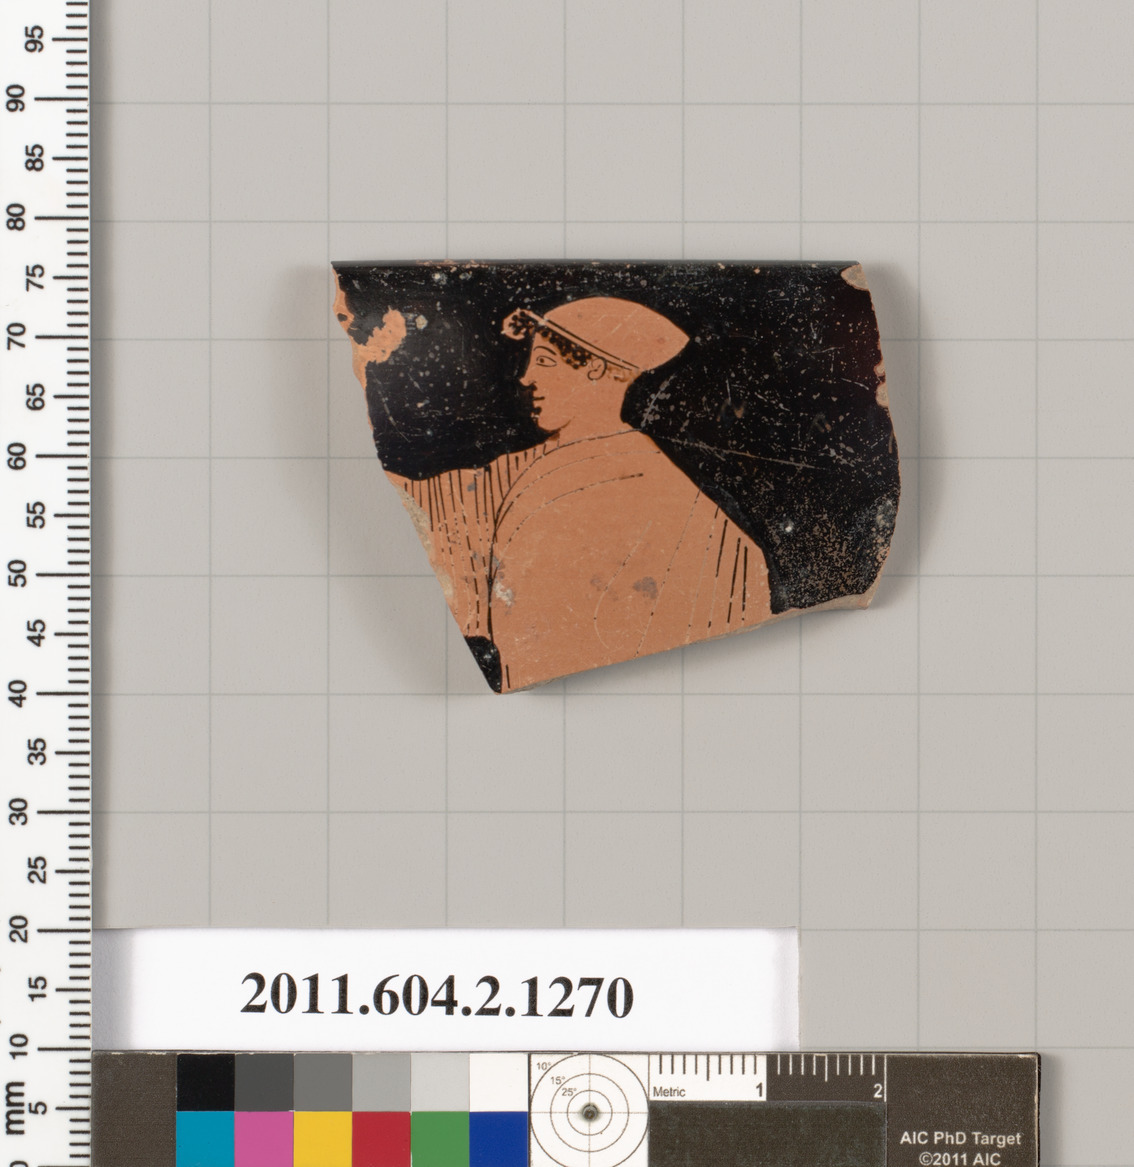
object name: skyphos fragment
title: Terracotta rim fragment of a skyphos (deep drinking cup)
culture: greek, attic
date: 460-450 BCE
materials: terracotta